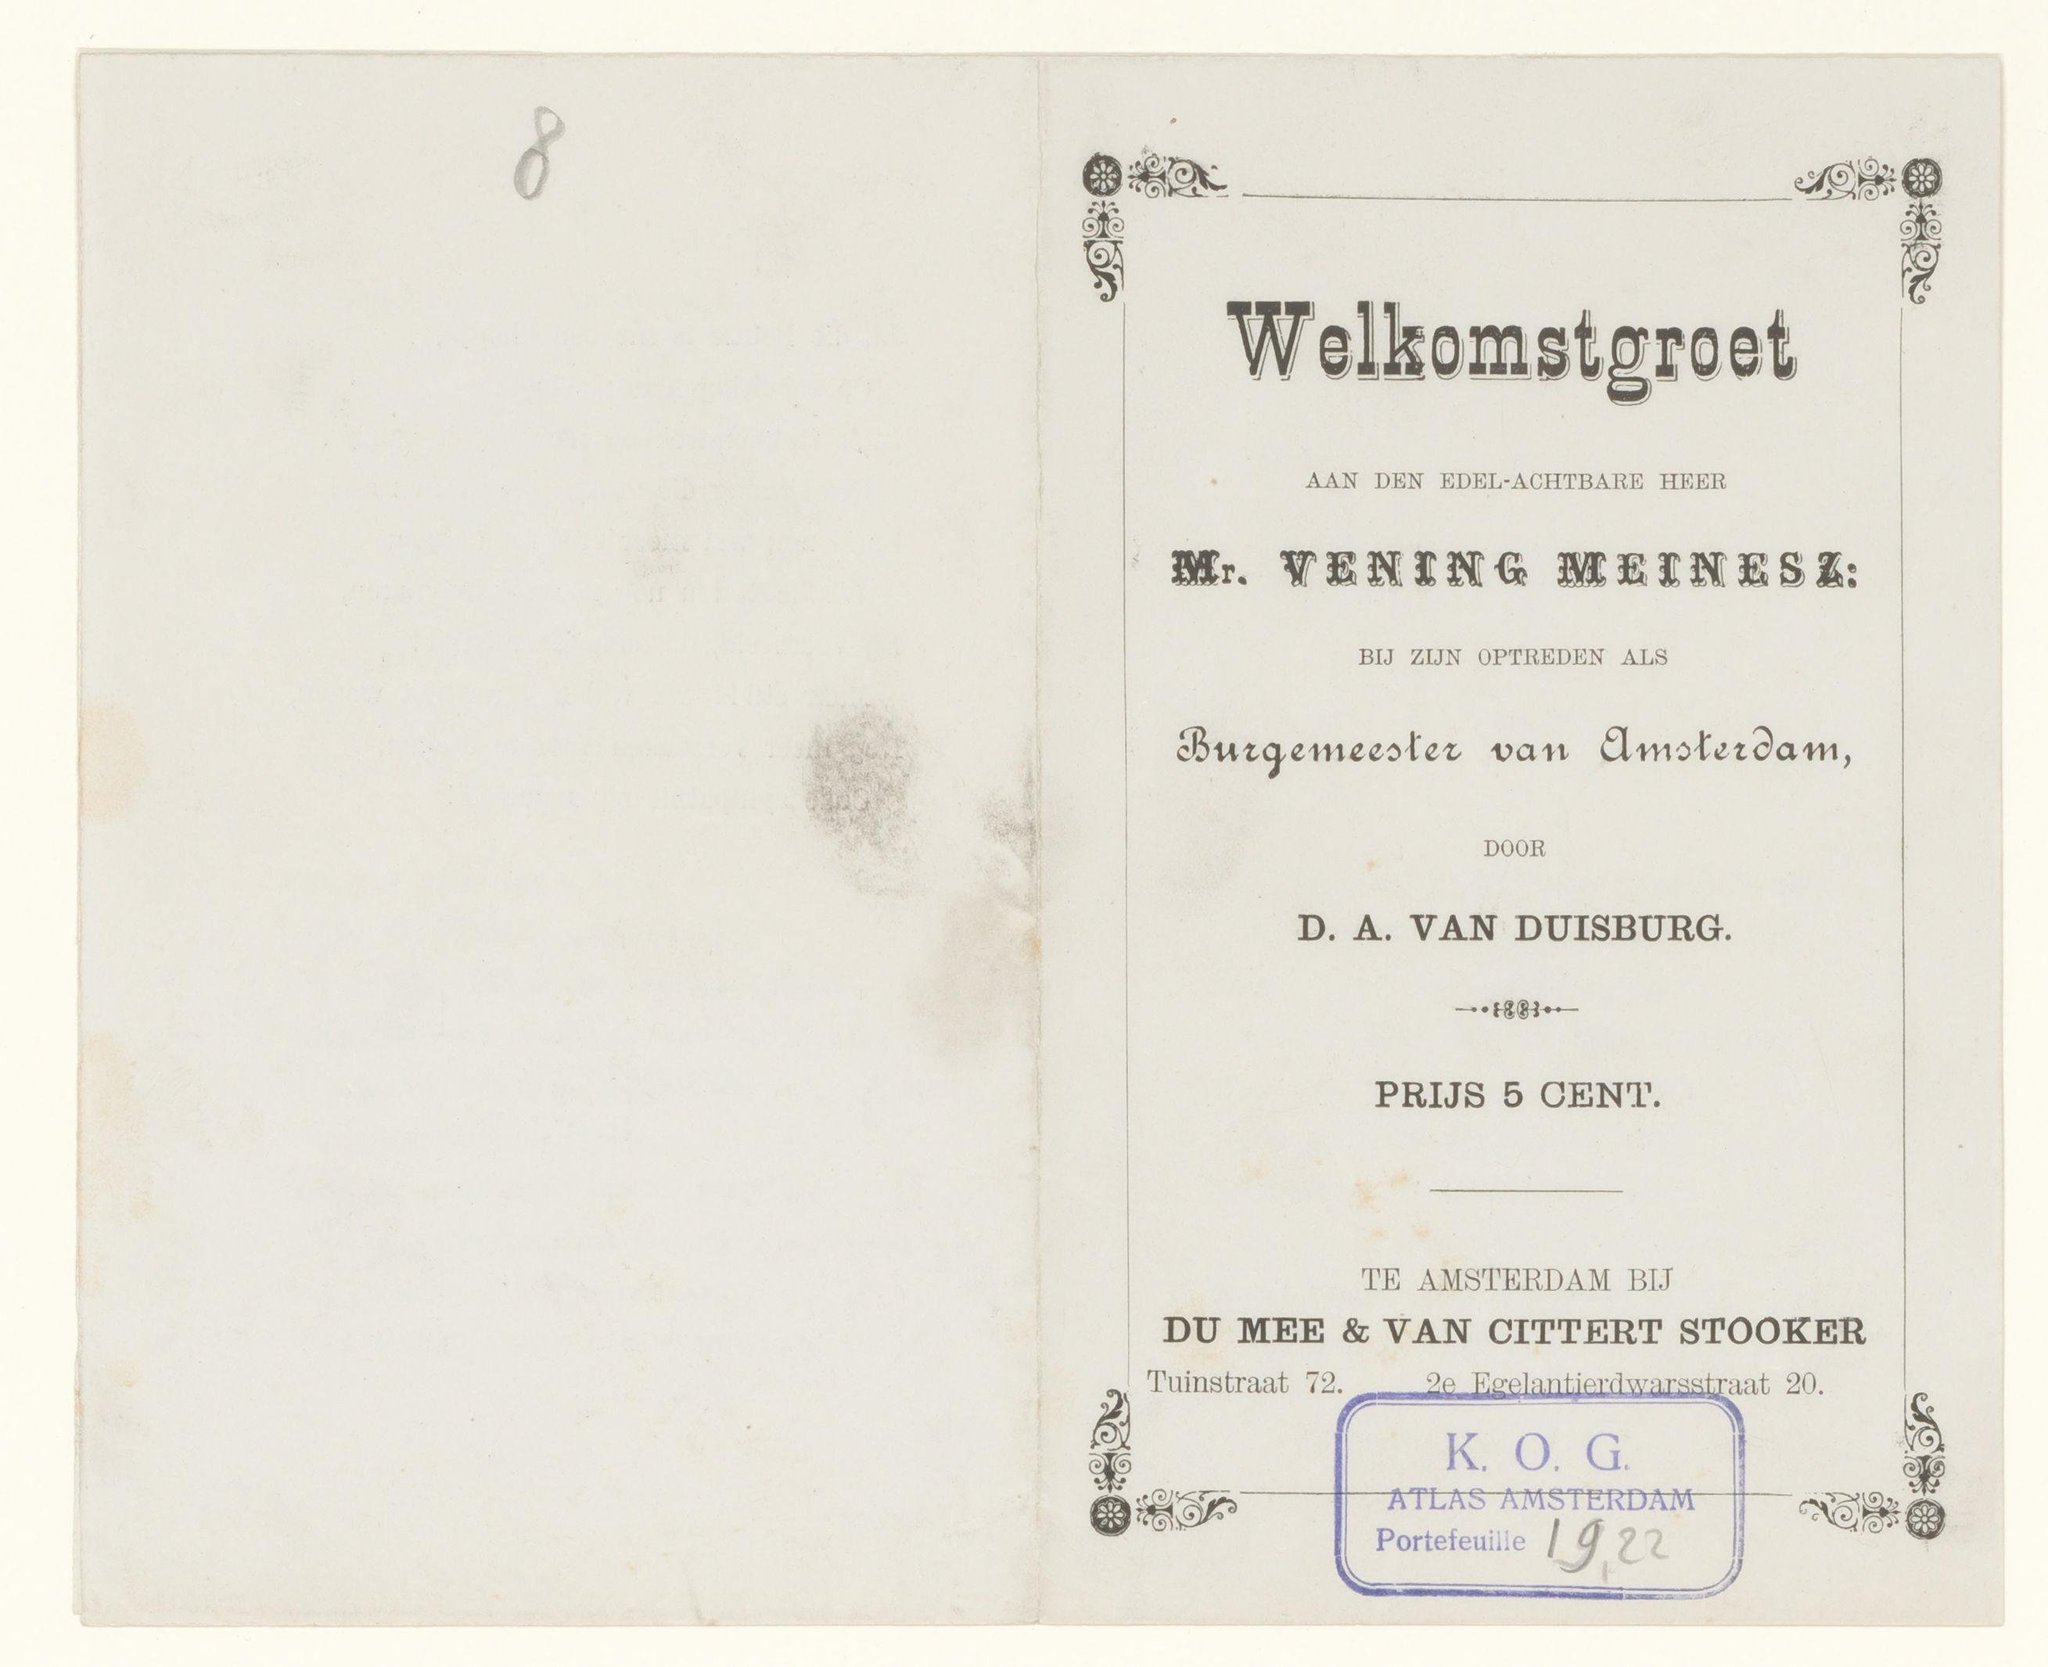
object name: text sheet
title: Aankondiging van de installatie van Sjoerd Anne Vening Meinesz als burgemeester van Amsterdam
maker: Anonymous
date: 1891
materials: paper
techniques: letterpress printing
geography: amsterdam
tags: harlingen, politician, mayor, burgomaster, installation of a ruler, amsterdam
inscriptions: name: ‘D.A. van Duisburg’, collector's mark: ‘19,22’ Lugt 1641b, name: ‘Du Mee & Van Cittert Stooker’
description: Onderwerpsrubriek binnen de Atlas Amsterdam: Herinneringen aan regeringsleden en hunne huisgezinnen [na 1800].